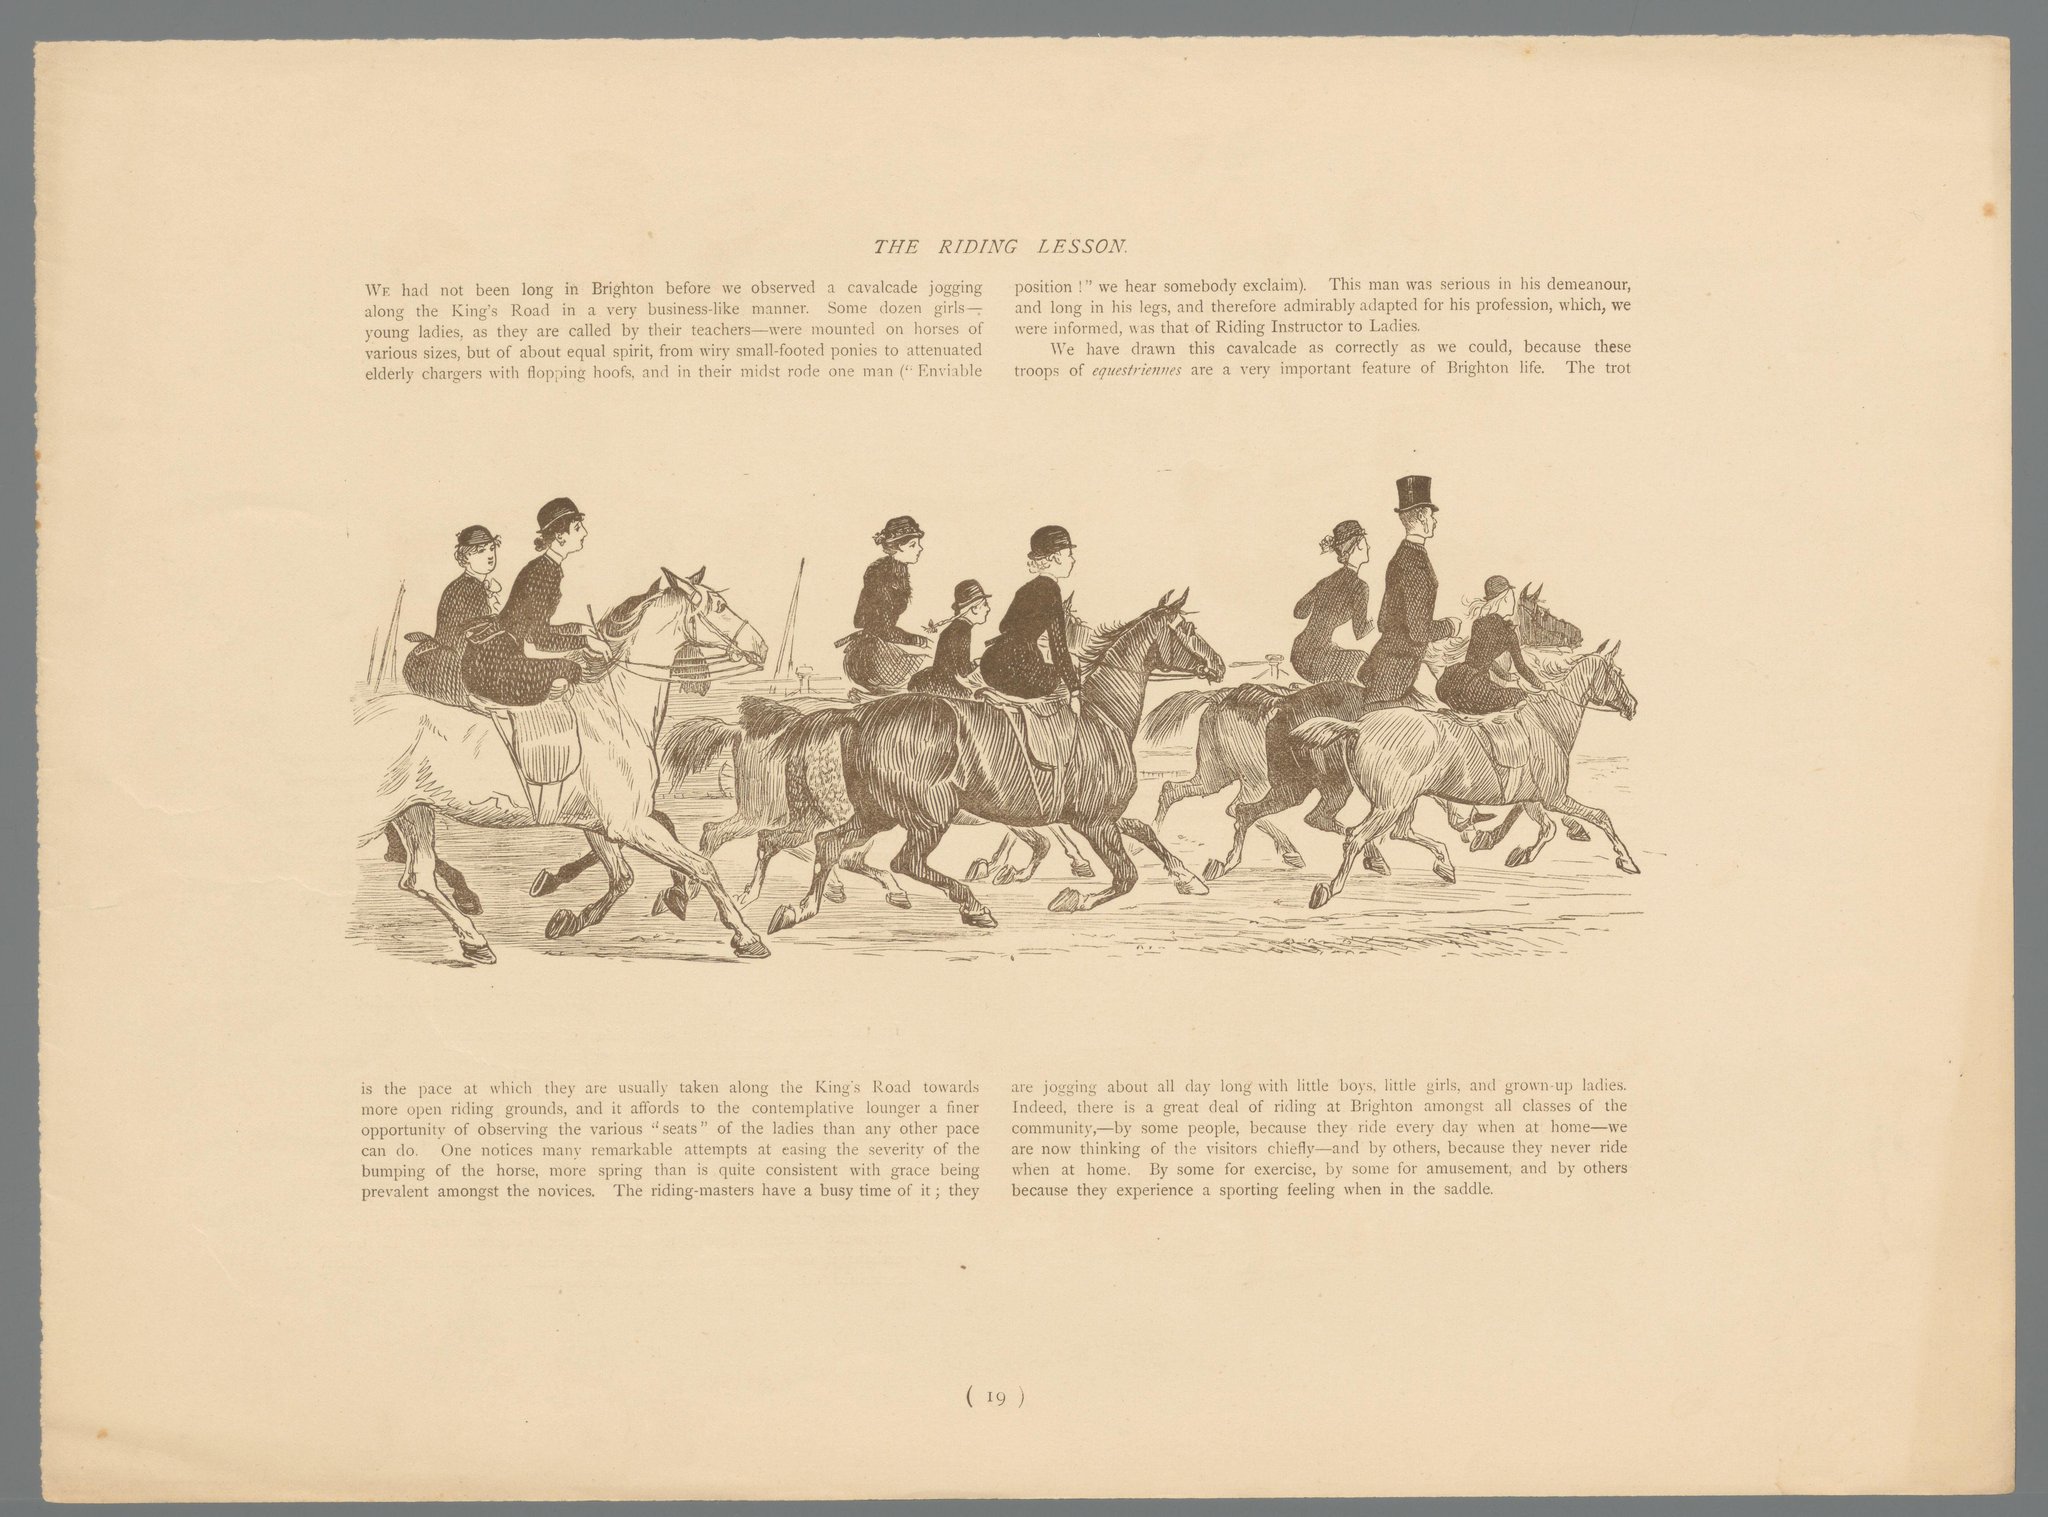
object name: book illustration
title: The riding lesson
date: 1889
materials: paper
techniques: letterpress printing, engraving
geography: london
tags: riding a horse, ass, or mule; rider, horseman, coast (+ landscape with figures, staffage)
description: Prent uit: Gleanings from the Graphic. Londen: George Routledge & Sons, 1889. Dit werk is een bundel van diverse illustraties die eerder verschenen in verschillende jaargangen van het Engelse weekblad 'The Graphic'. De bundel is na het overlijden van Randolph Caldecott uitgegeven.